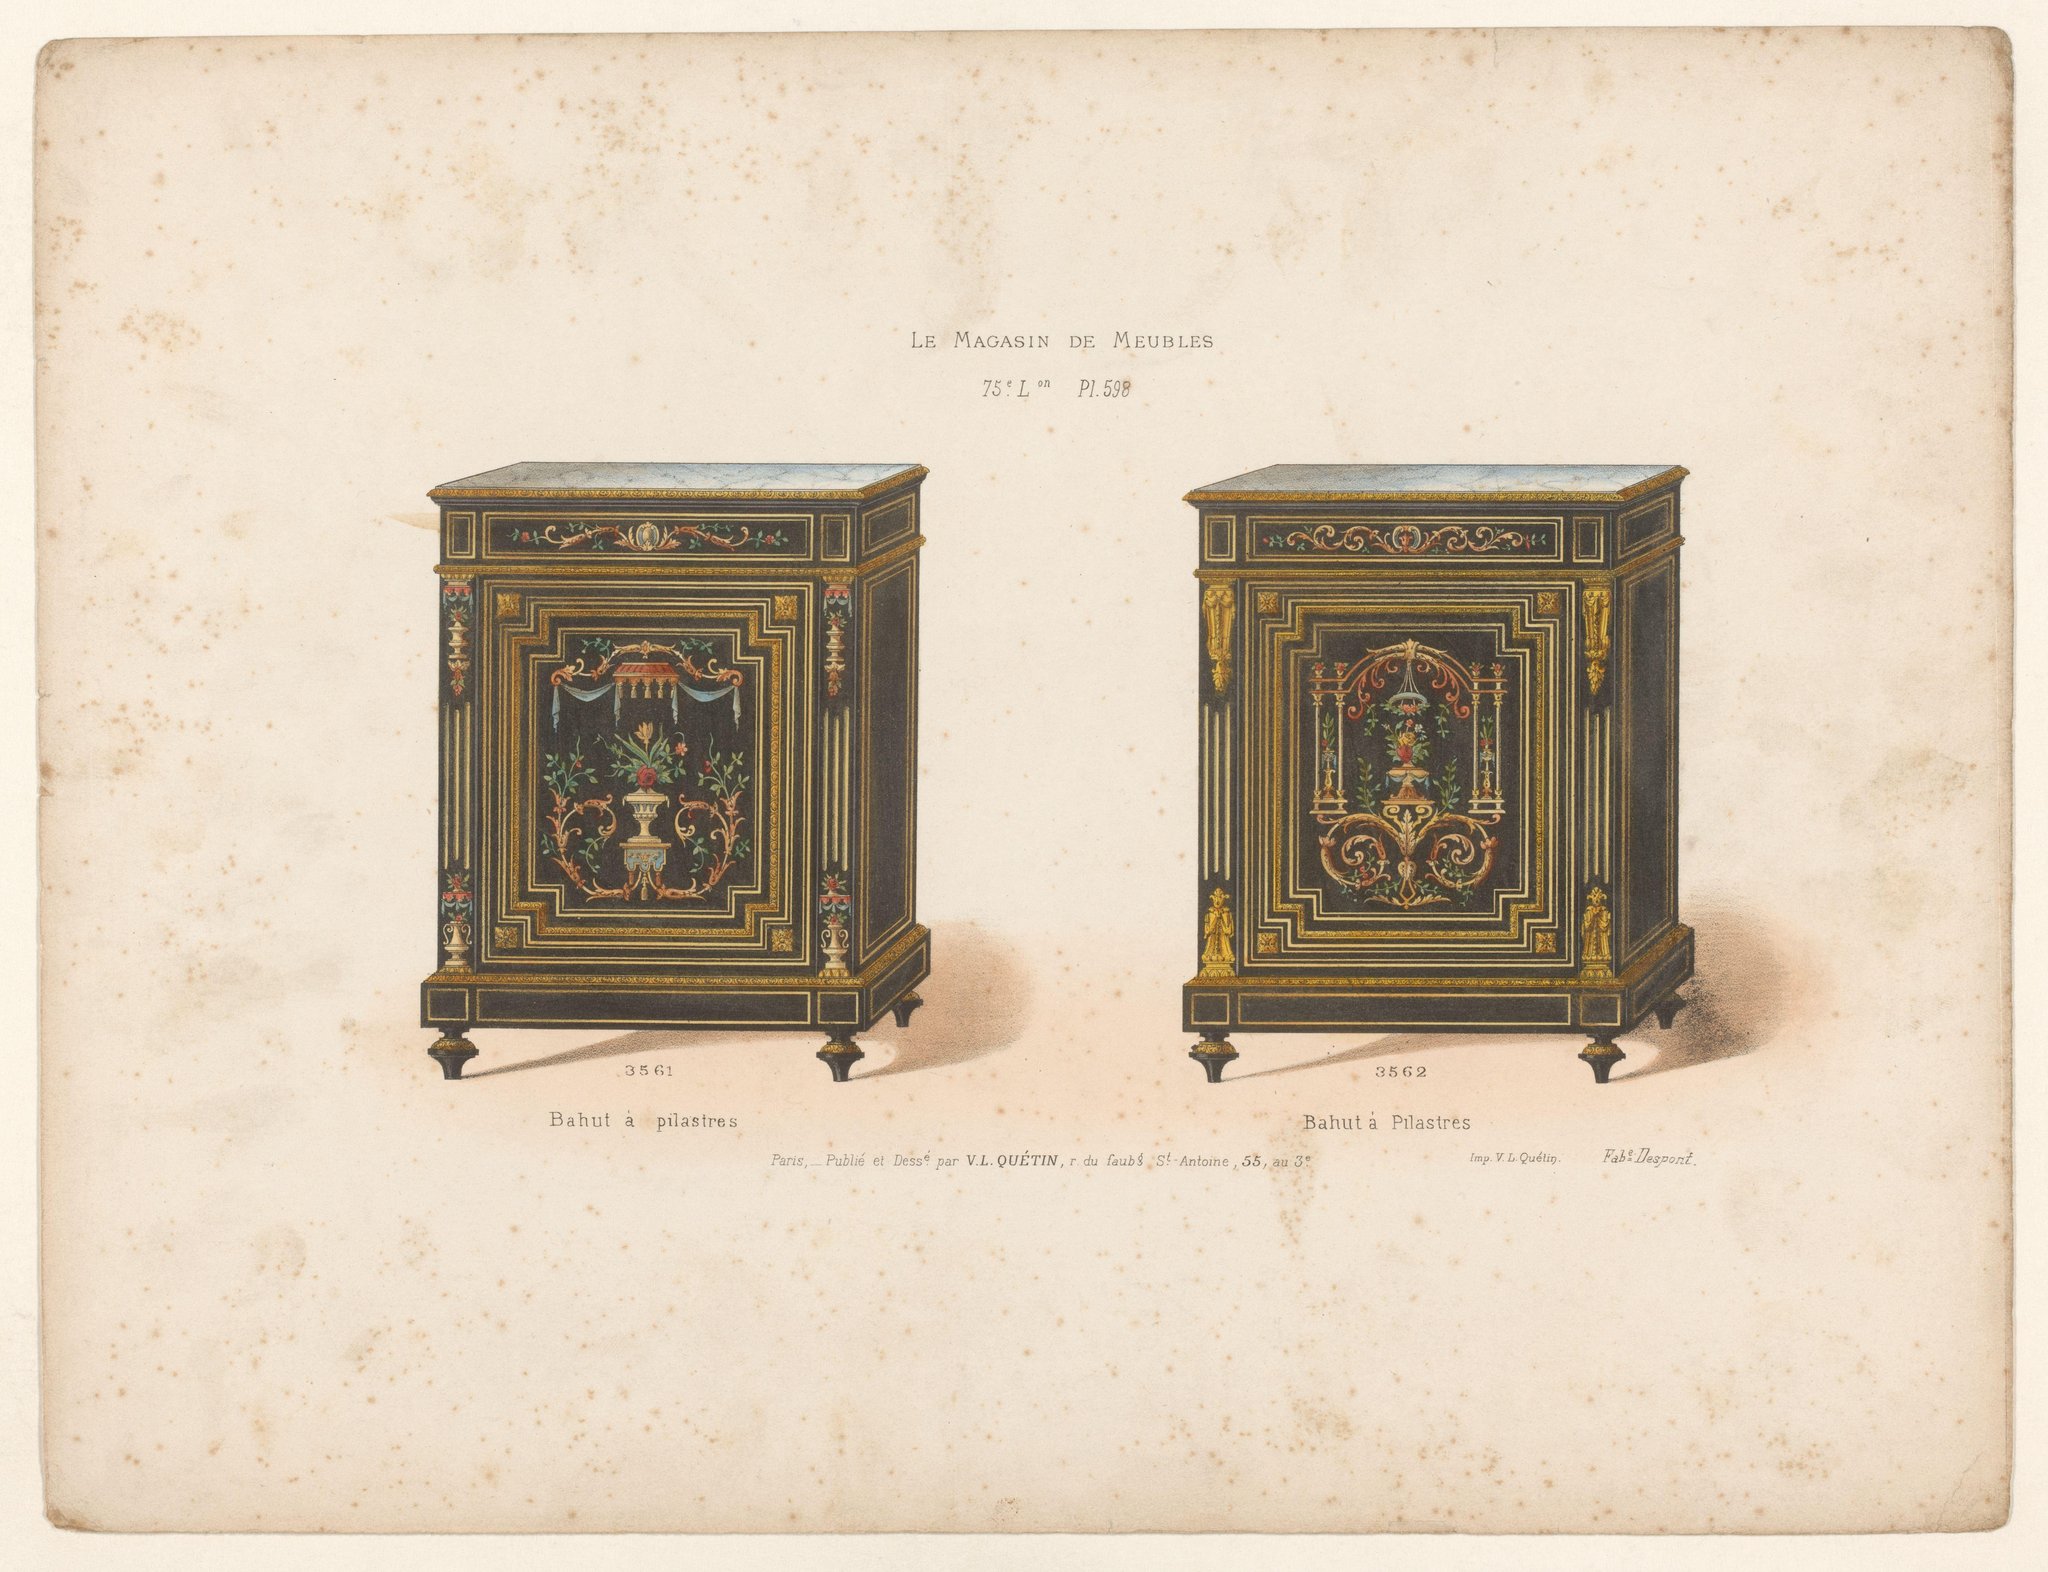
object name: print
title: Le Magasin de Meubles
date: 1878-1904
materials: paper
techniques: hand coloring, lithograph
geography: paris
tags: furniture for storage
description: Twee lage kasten. Prent uit 75e Livraison.